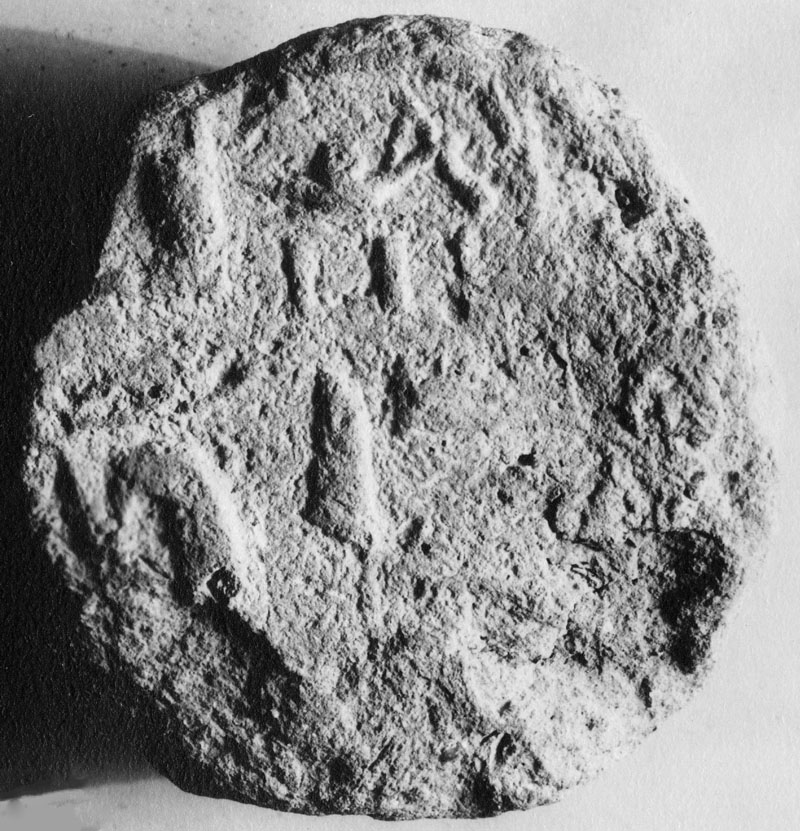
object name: cone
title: Funerary Cone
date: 1550-1295 BCE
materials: pottery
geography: egypt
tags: hieroglyphs